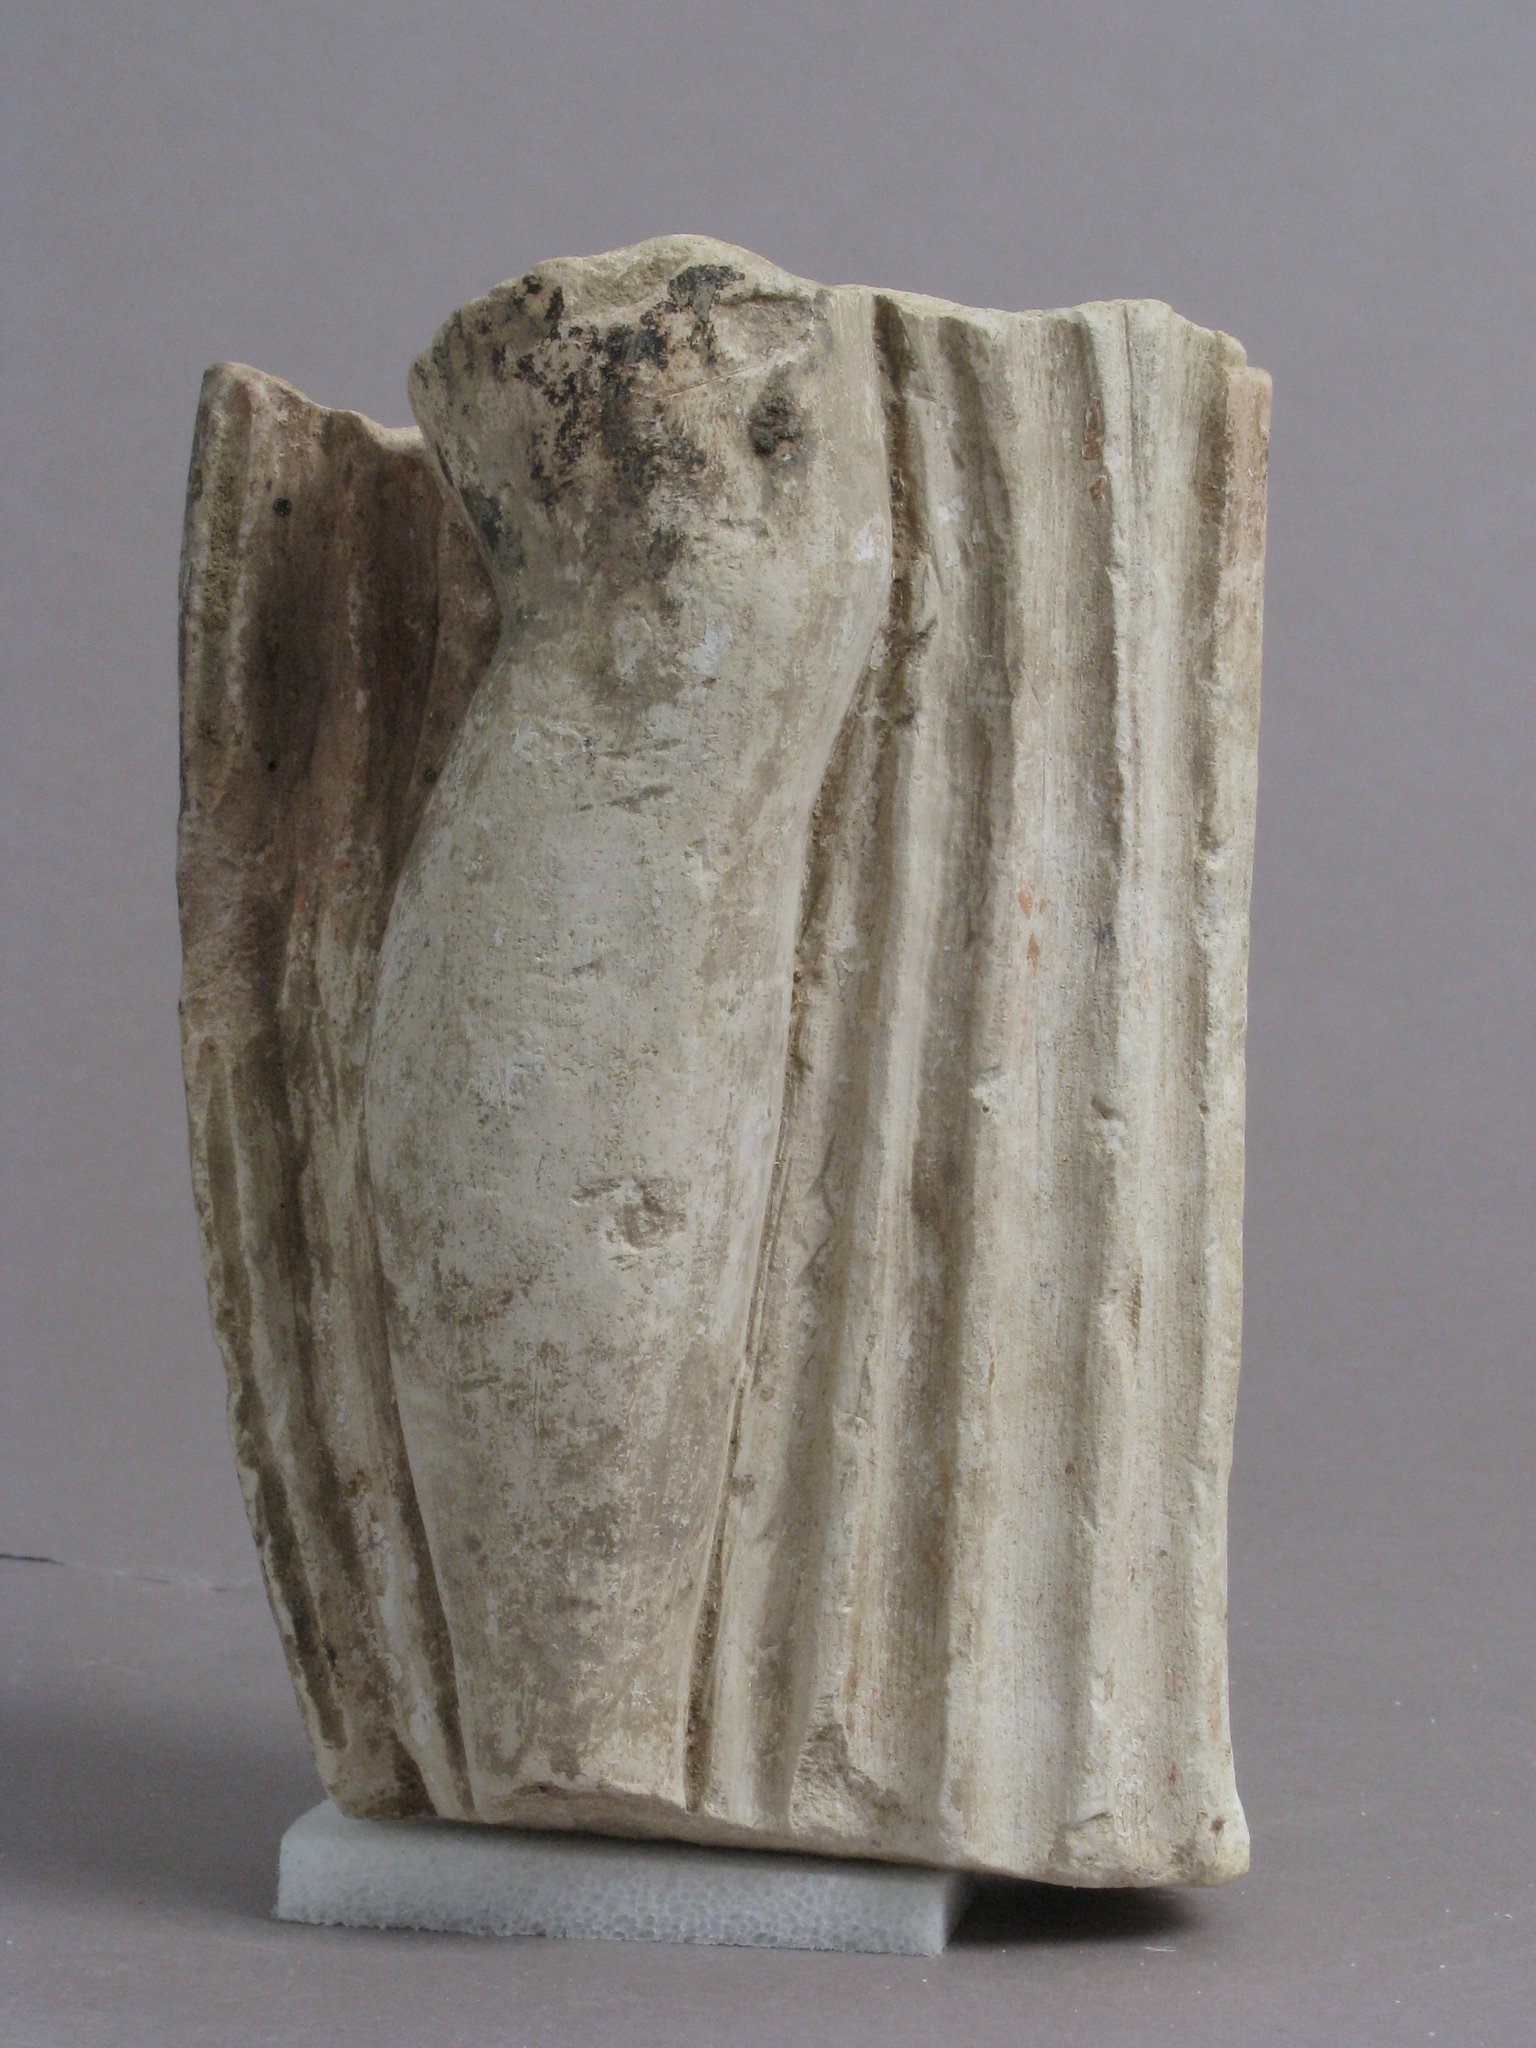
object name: statuette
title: Knee Fragment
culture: coptic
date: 301-700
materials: marble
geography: egypt